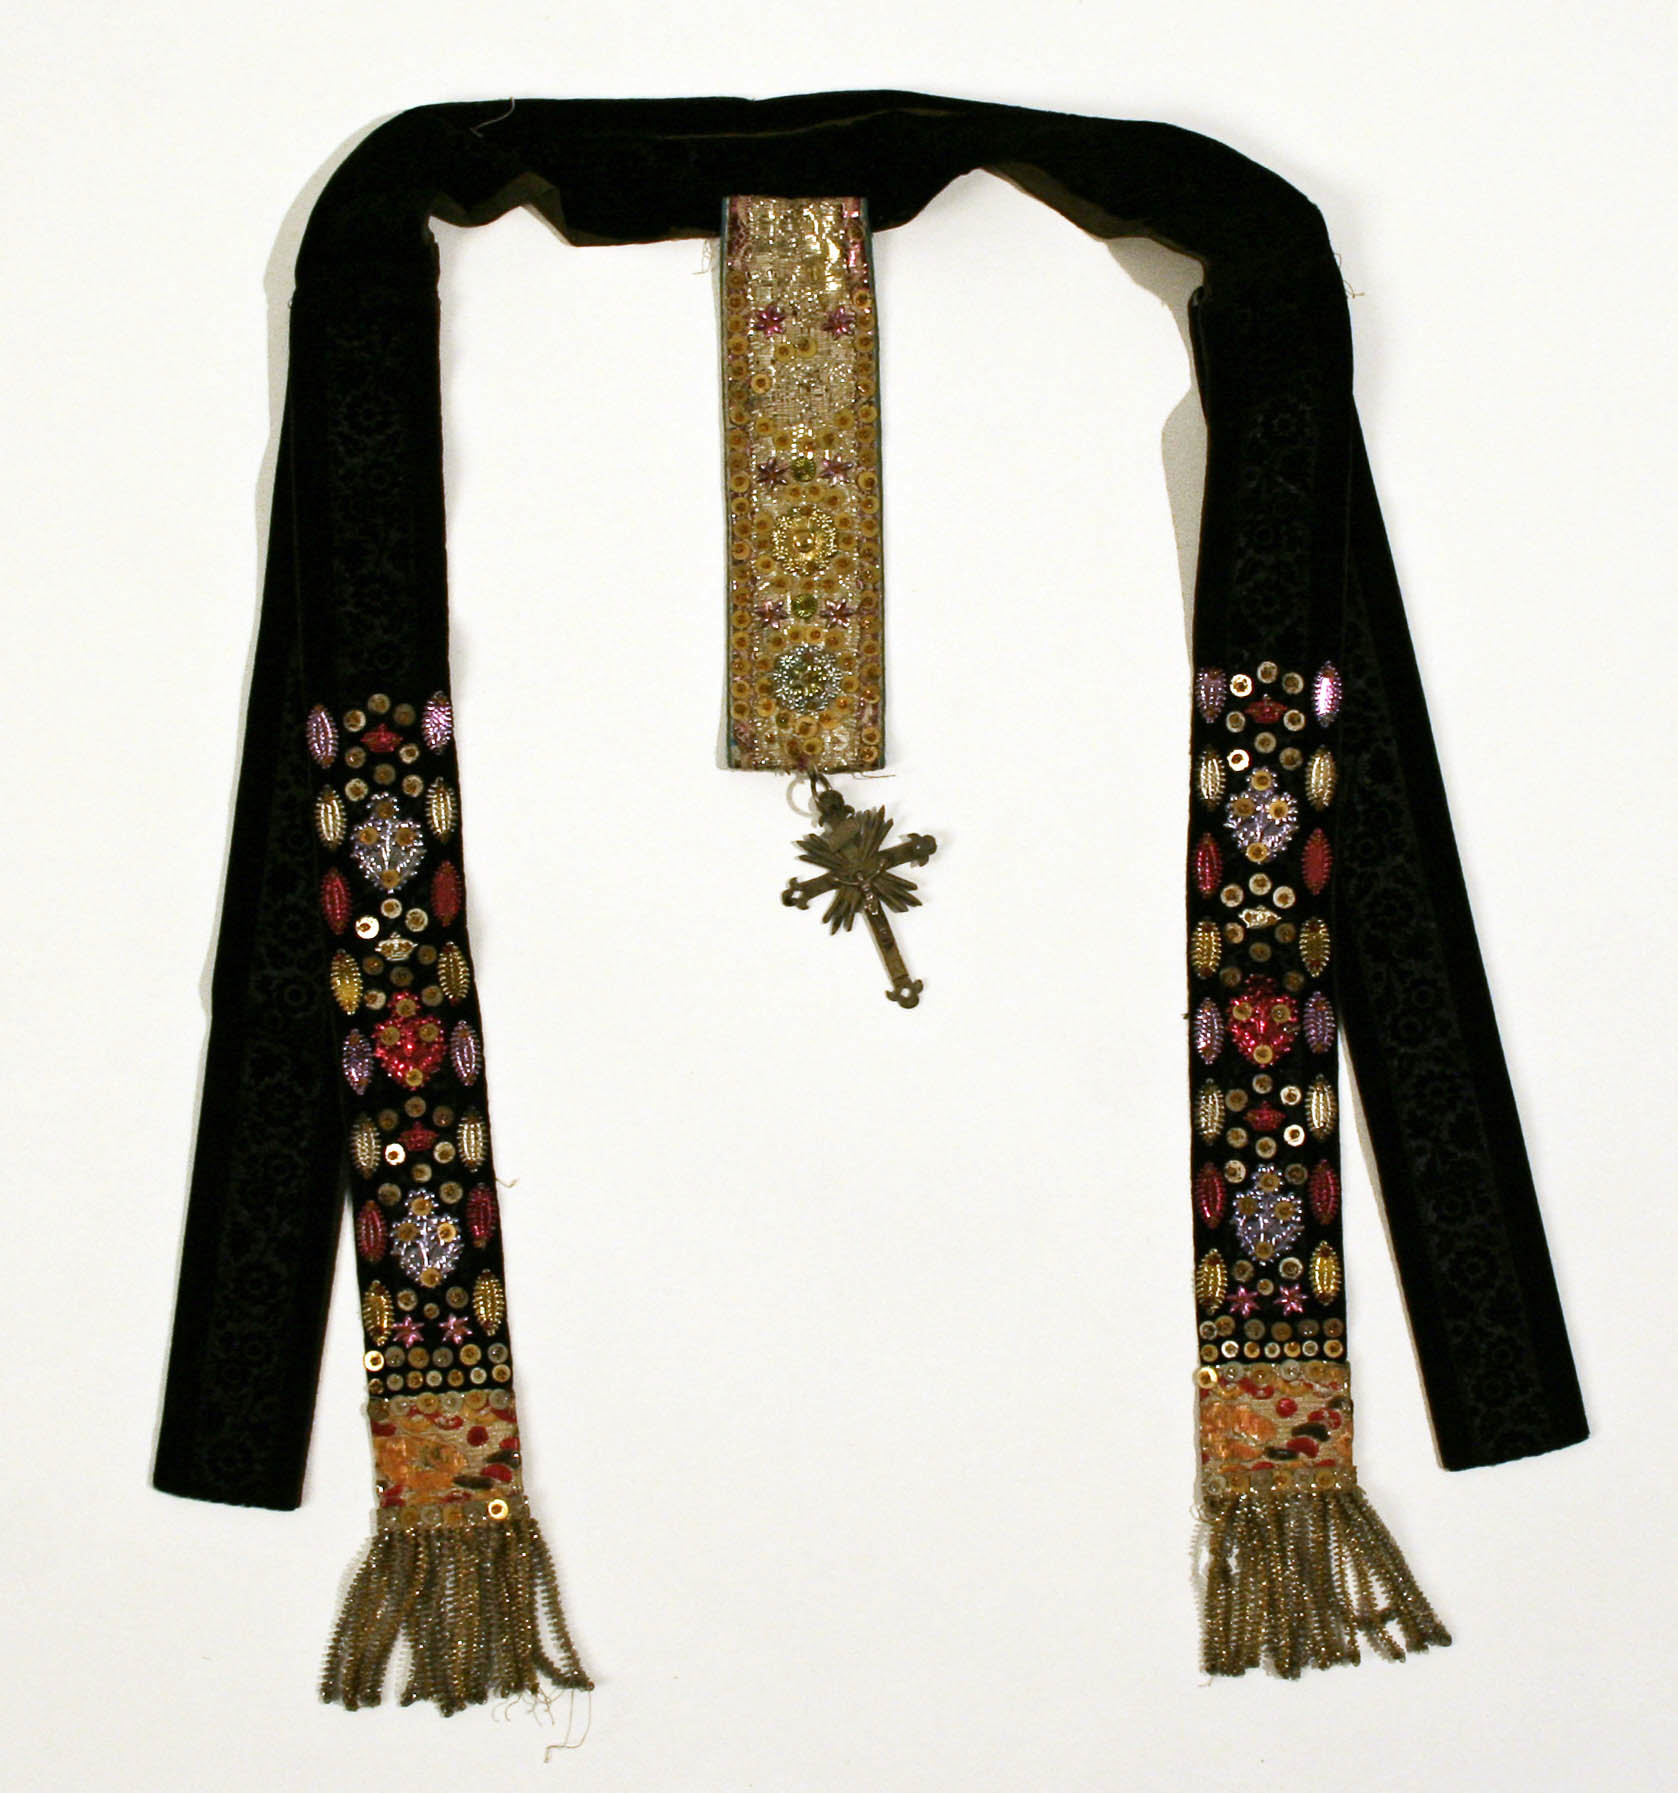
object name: ribbon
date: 1867-1933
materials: metal, silk